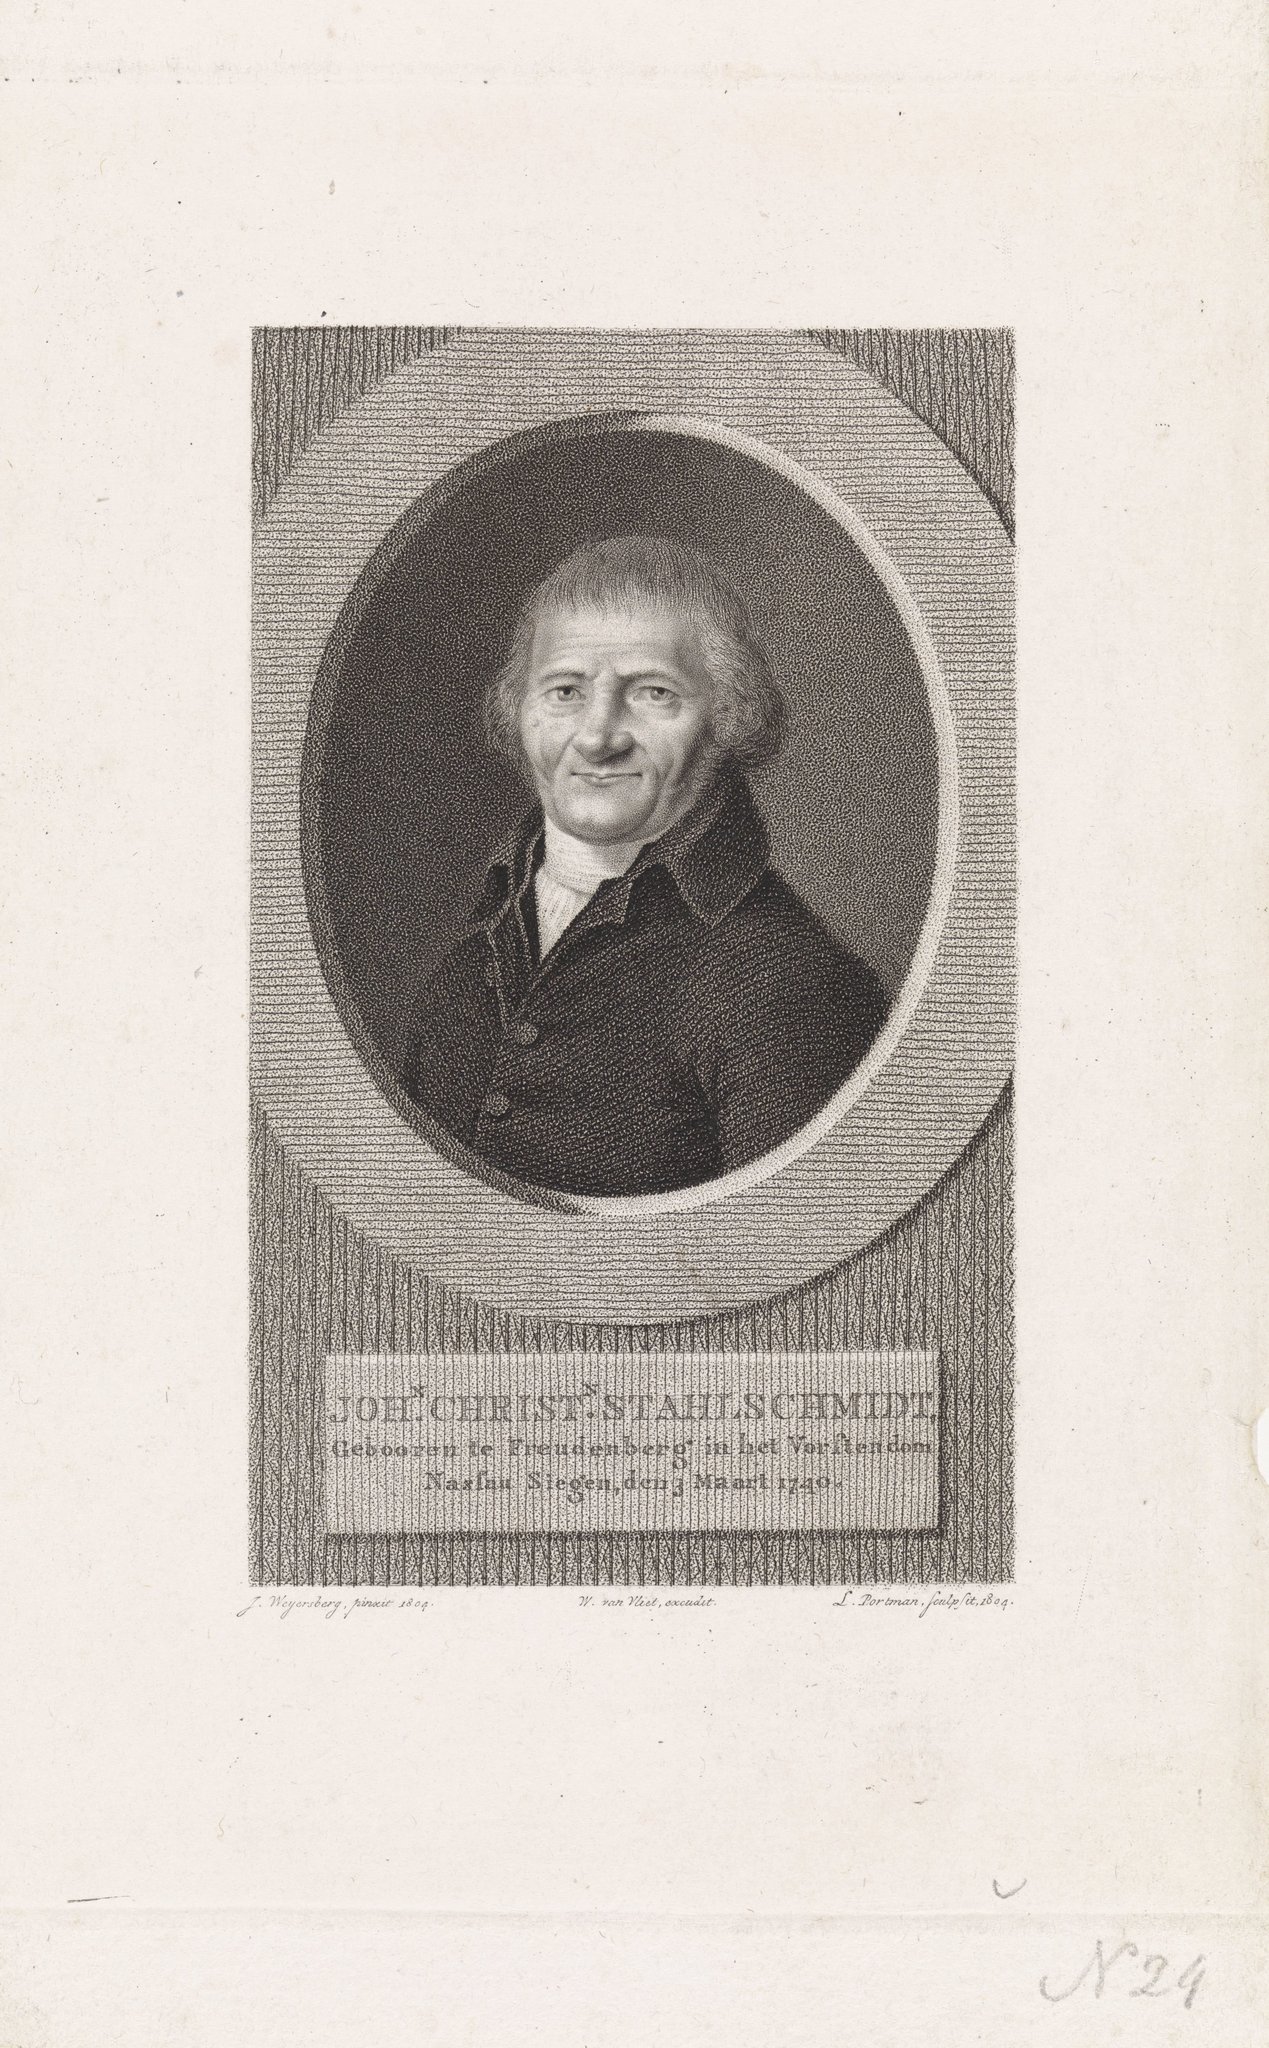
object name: print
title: Portret van Johann Christian Stahlschmidt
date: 1804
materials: paper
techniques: etching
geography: amsterdam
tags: predikant, johann christian stahlschmidt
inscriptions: collector's mark: Lugt 2228